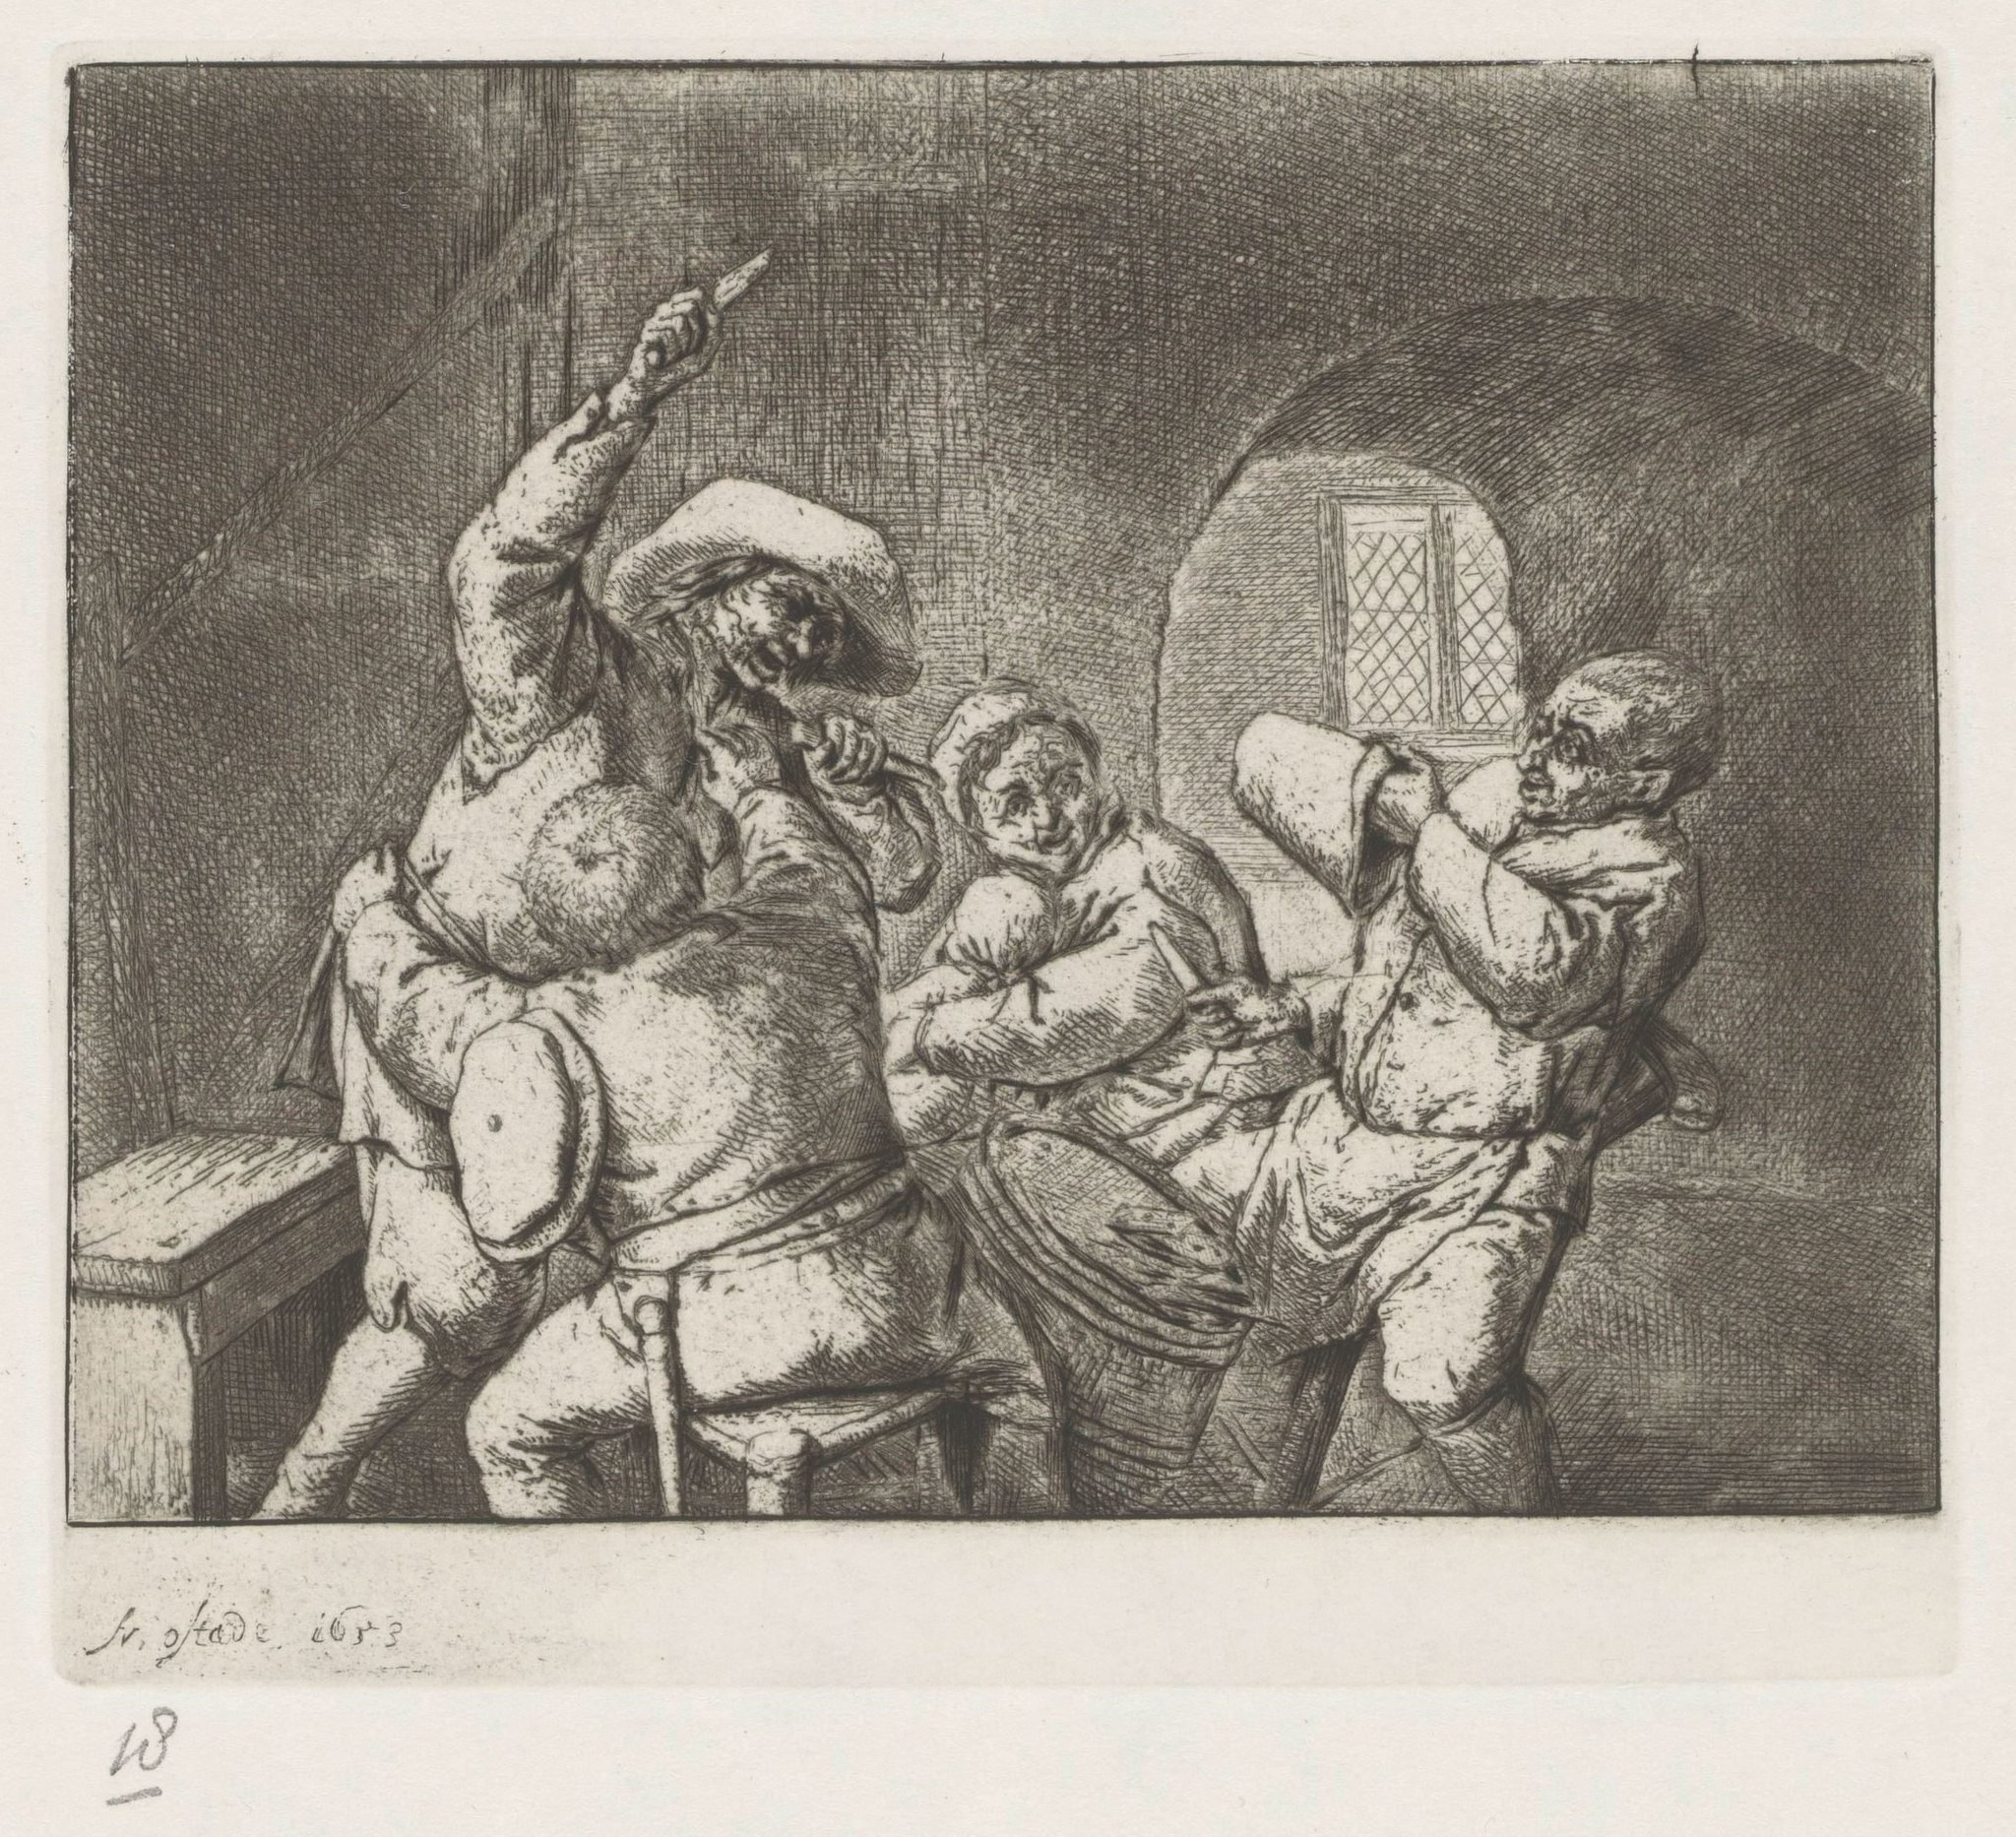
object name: print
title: Vechtende kaartspelers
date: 1653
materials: paper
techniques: etching, galvanization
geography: haarlem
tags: card games, drunken brawl (usually peasants fighting in an inn)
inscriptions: collector's mark: ‘RIJKS / MUSM’, collector's mark: ‘B’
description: In een interieur van een herberg springt een man op van een kruk en zwaait dreigend met een getrokken mes. Zijn tegenstander deinst verschrikt achteruit en houdt in verweer zijn hoed voor zijn borst. Een zittende man probeert de boze man te kalmeren en een vrouw slaat beschermend een arm om het kind op haar schoot. De aanleiding voor dit gevecht is een kaartspel dat bovenop een ton ligt welke door het tumult omvalt. De prent maakt deel uit van een portefeuille en is met een andere prent op één albumblad gedrukt.